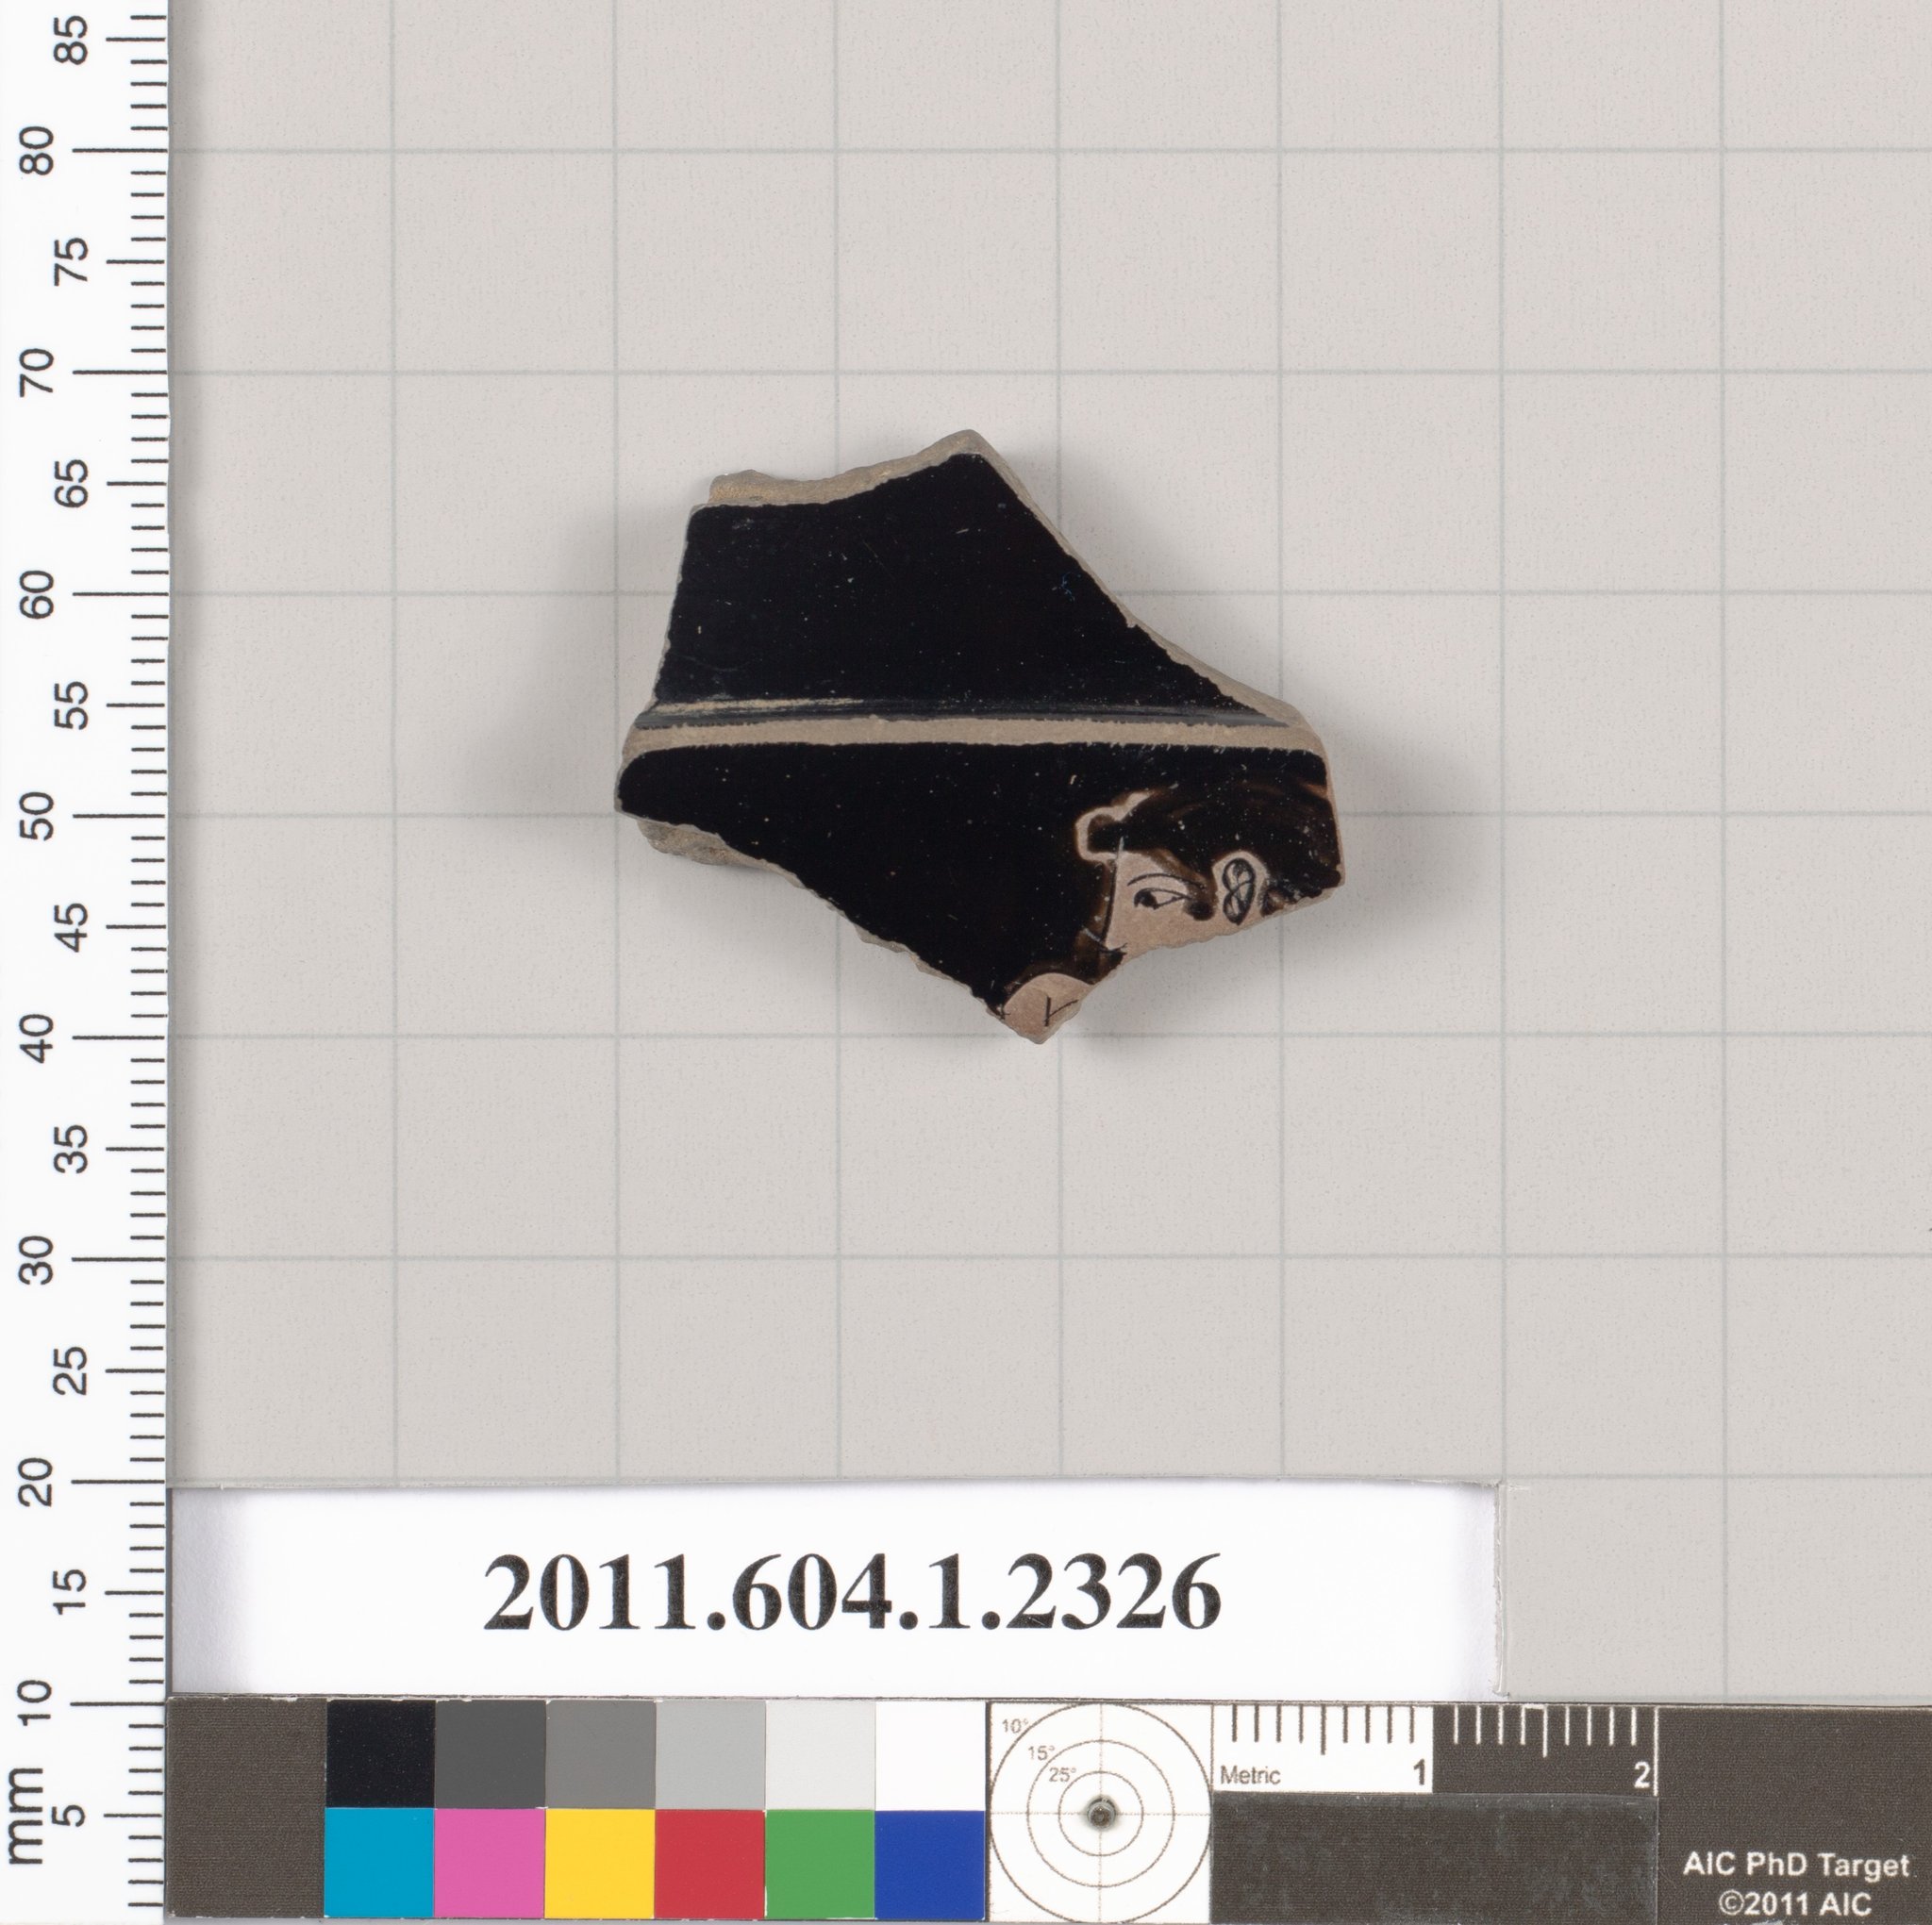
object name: kylix fragment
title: Terracotta fragment of a kylix (drinking cup)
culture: greek, attic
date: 475-451 BCE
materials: terracotta